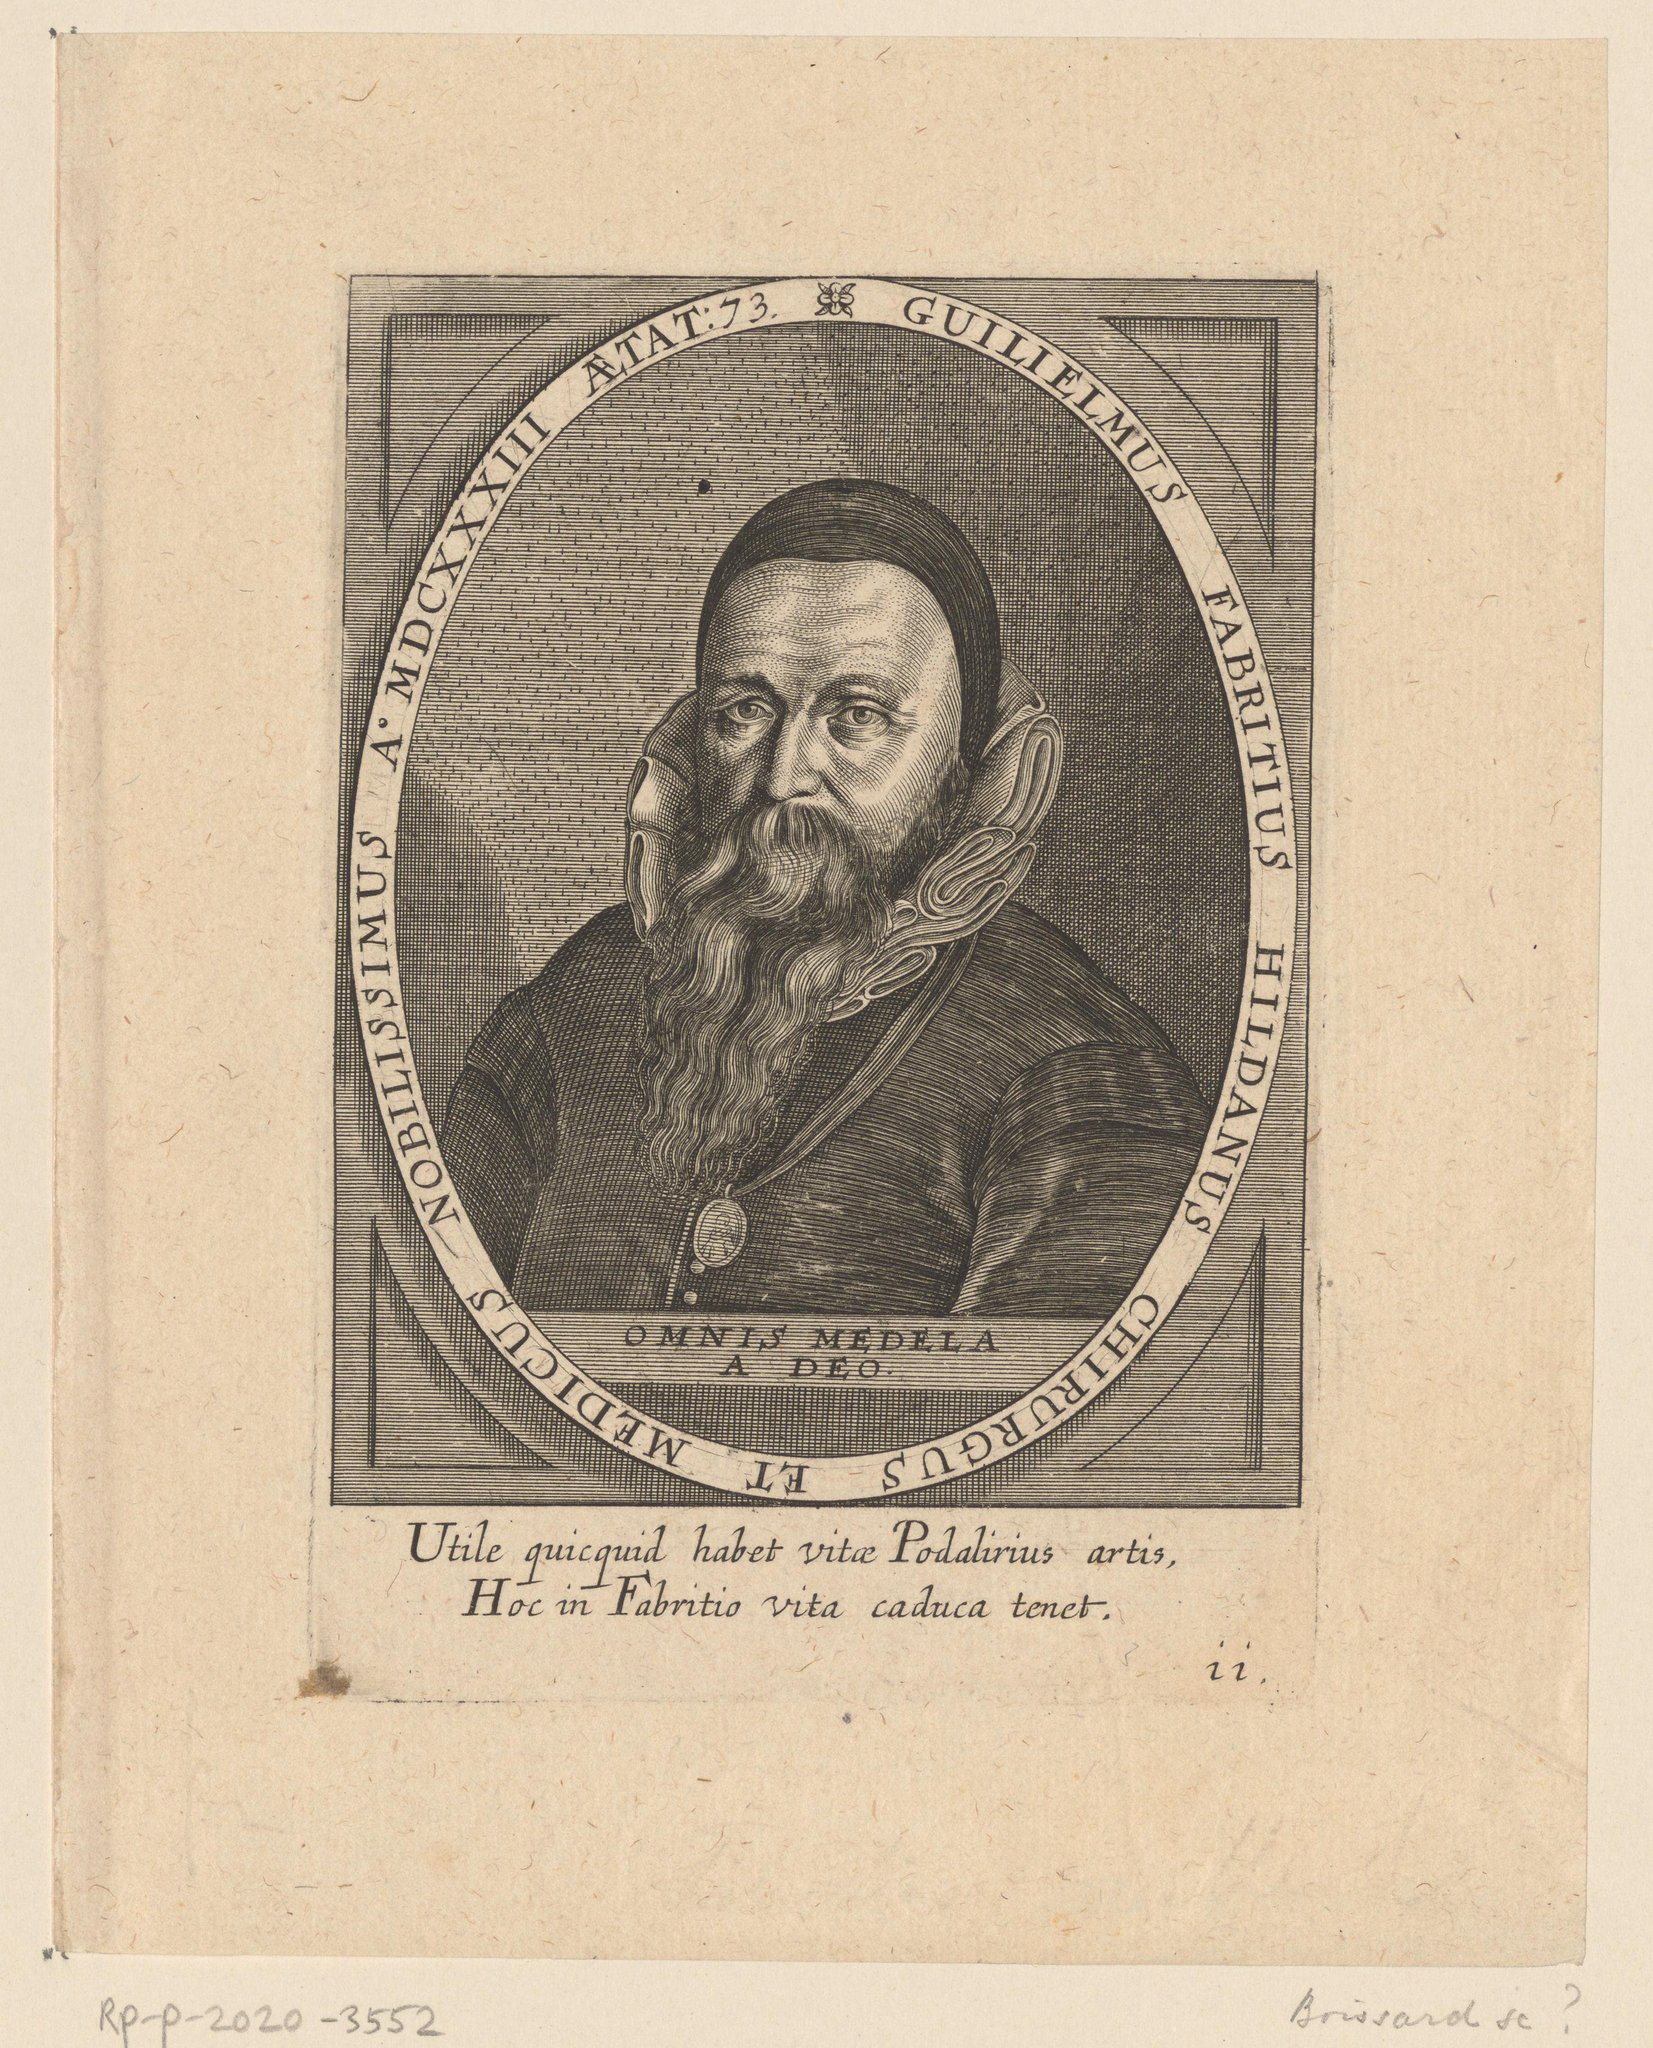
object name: print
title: Portret van Wilhelm Fabry op 73-jarige leeftijd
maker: Anonymous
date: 1633-1650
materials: paper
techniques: engraving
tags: historical persons, barber; surgeon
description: Met twee regels in het Latijn onder het portret. Rechtsonder vermeld: ii.